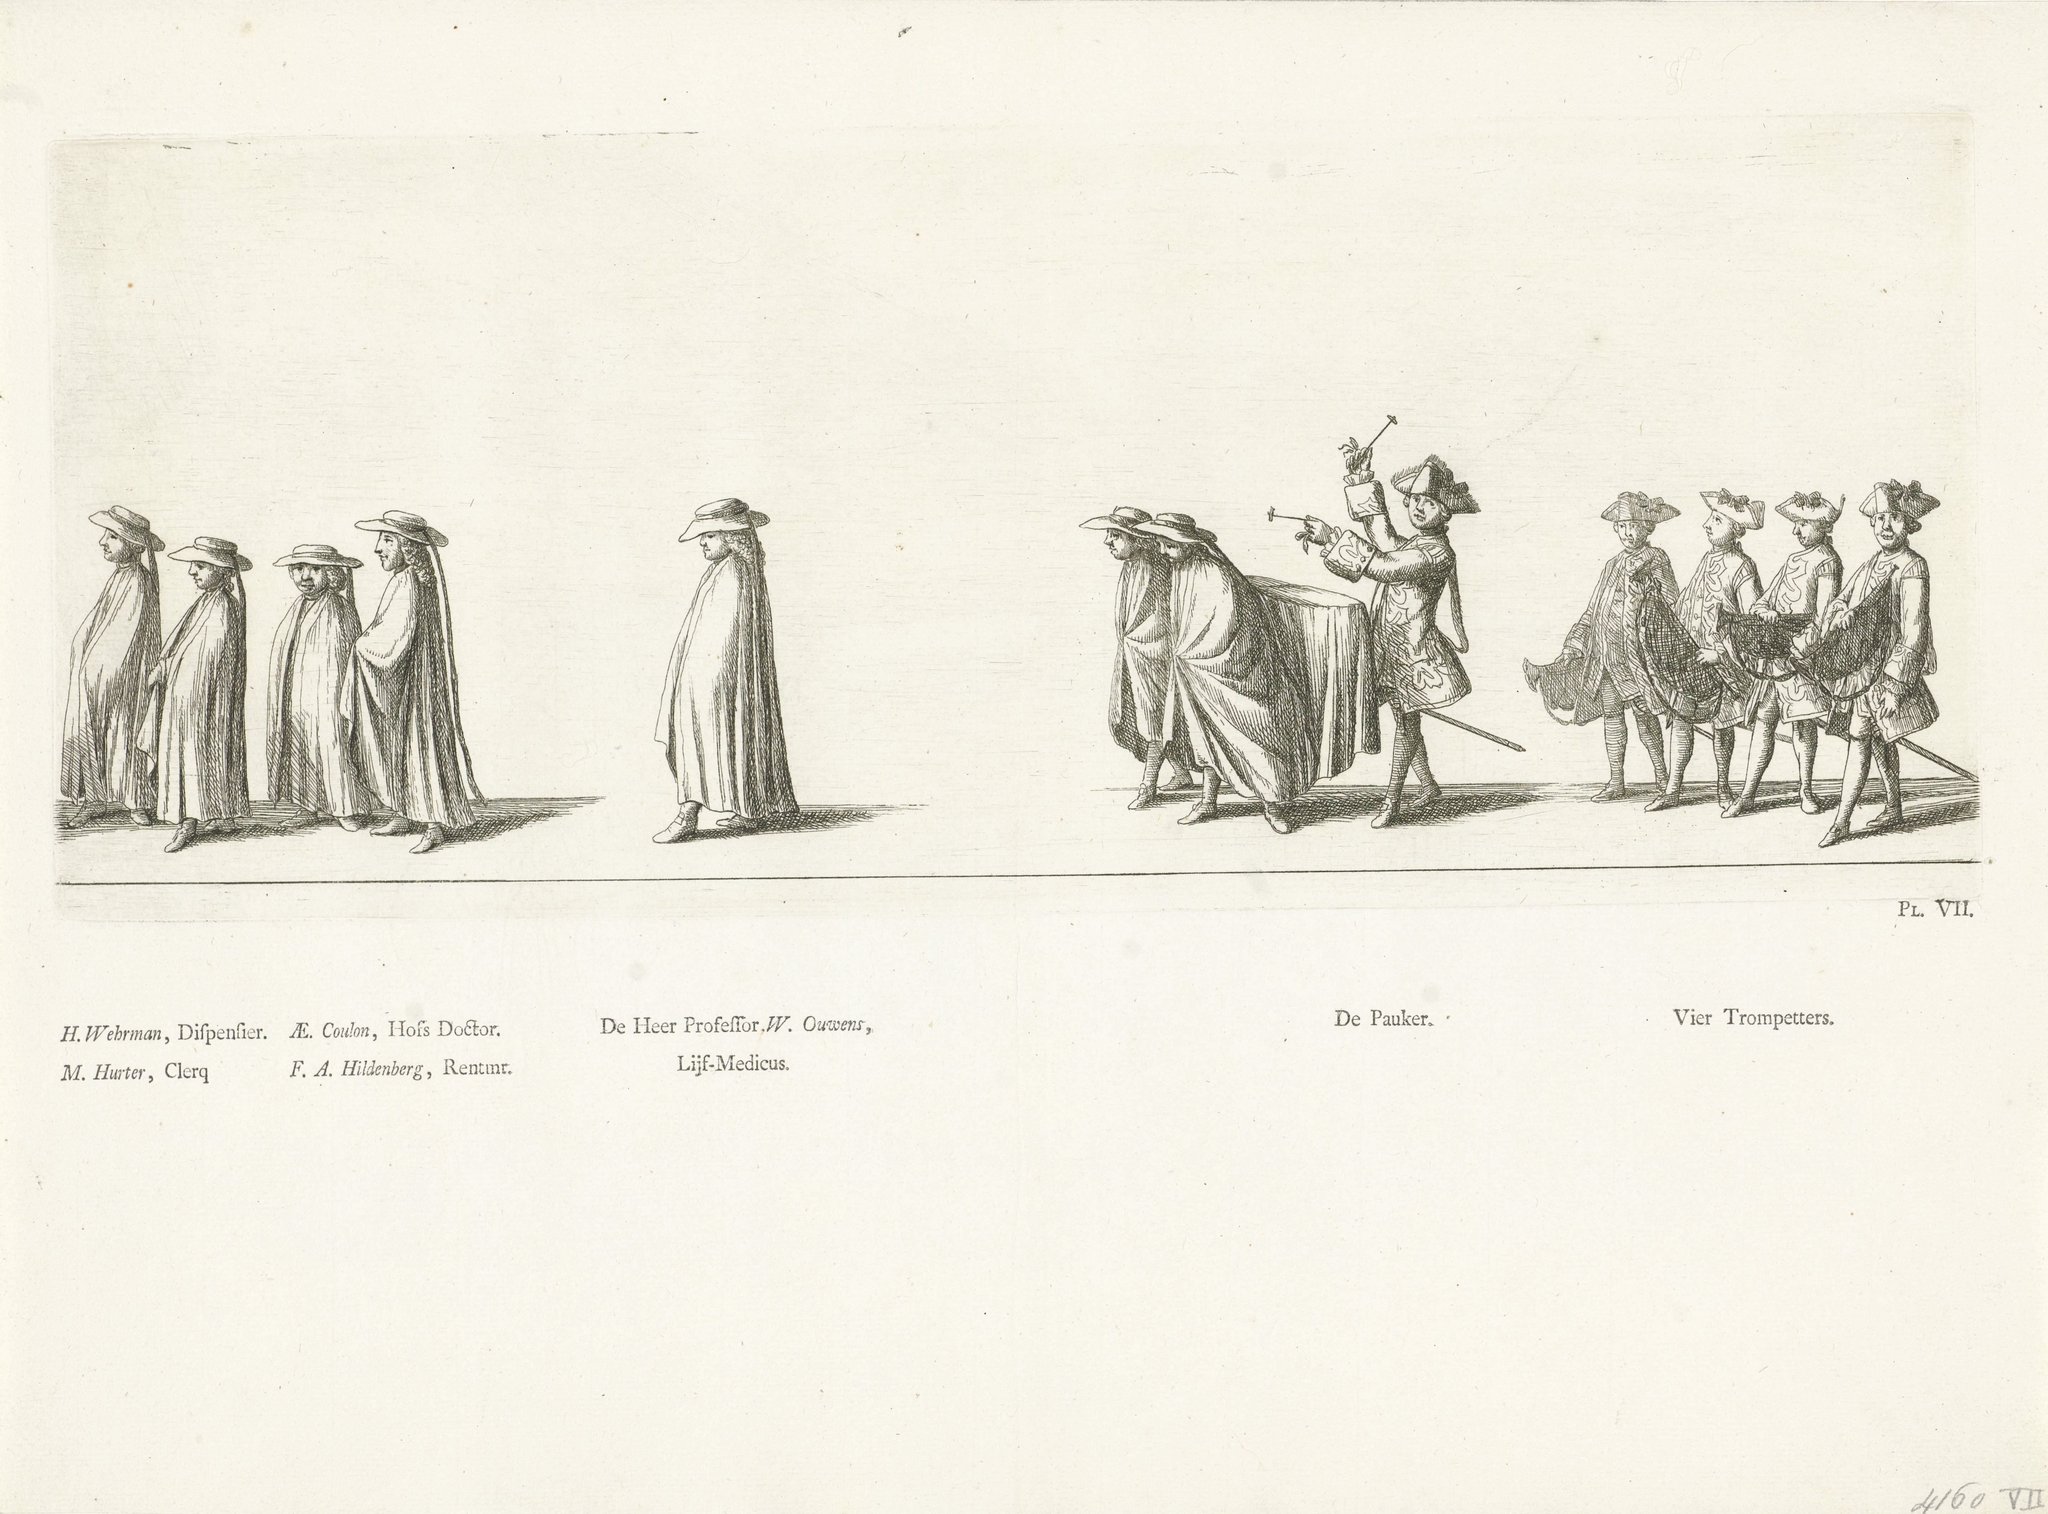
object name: print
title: Hofhouding en muzikanten in de begrafenisstoet van prinses Maria Louise, 1765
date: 1765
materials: paper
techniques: etching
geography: leeuwarden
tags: military music, cortege, funeral procession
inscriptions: date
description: De leden van de stadhouderlijke hofhouding, een paukenier en vier trompetters. Gemerkt rechtsonder: Pl. VII. Op het blad onder de plaat de namen van personen in de stoet. Onderdeel van de serie platen van de begrafenis van prinses Maria Louise te Leeuwarden op 13 juni 1765.